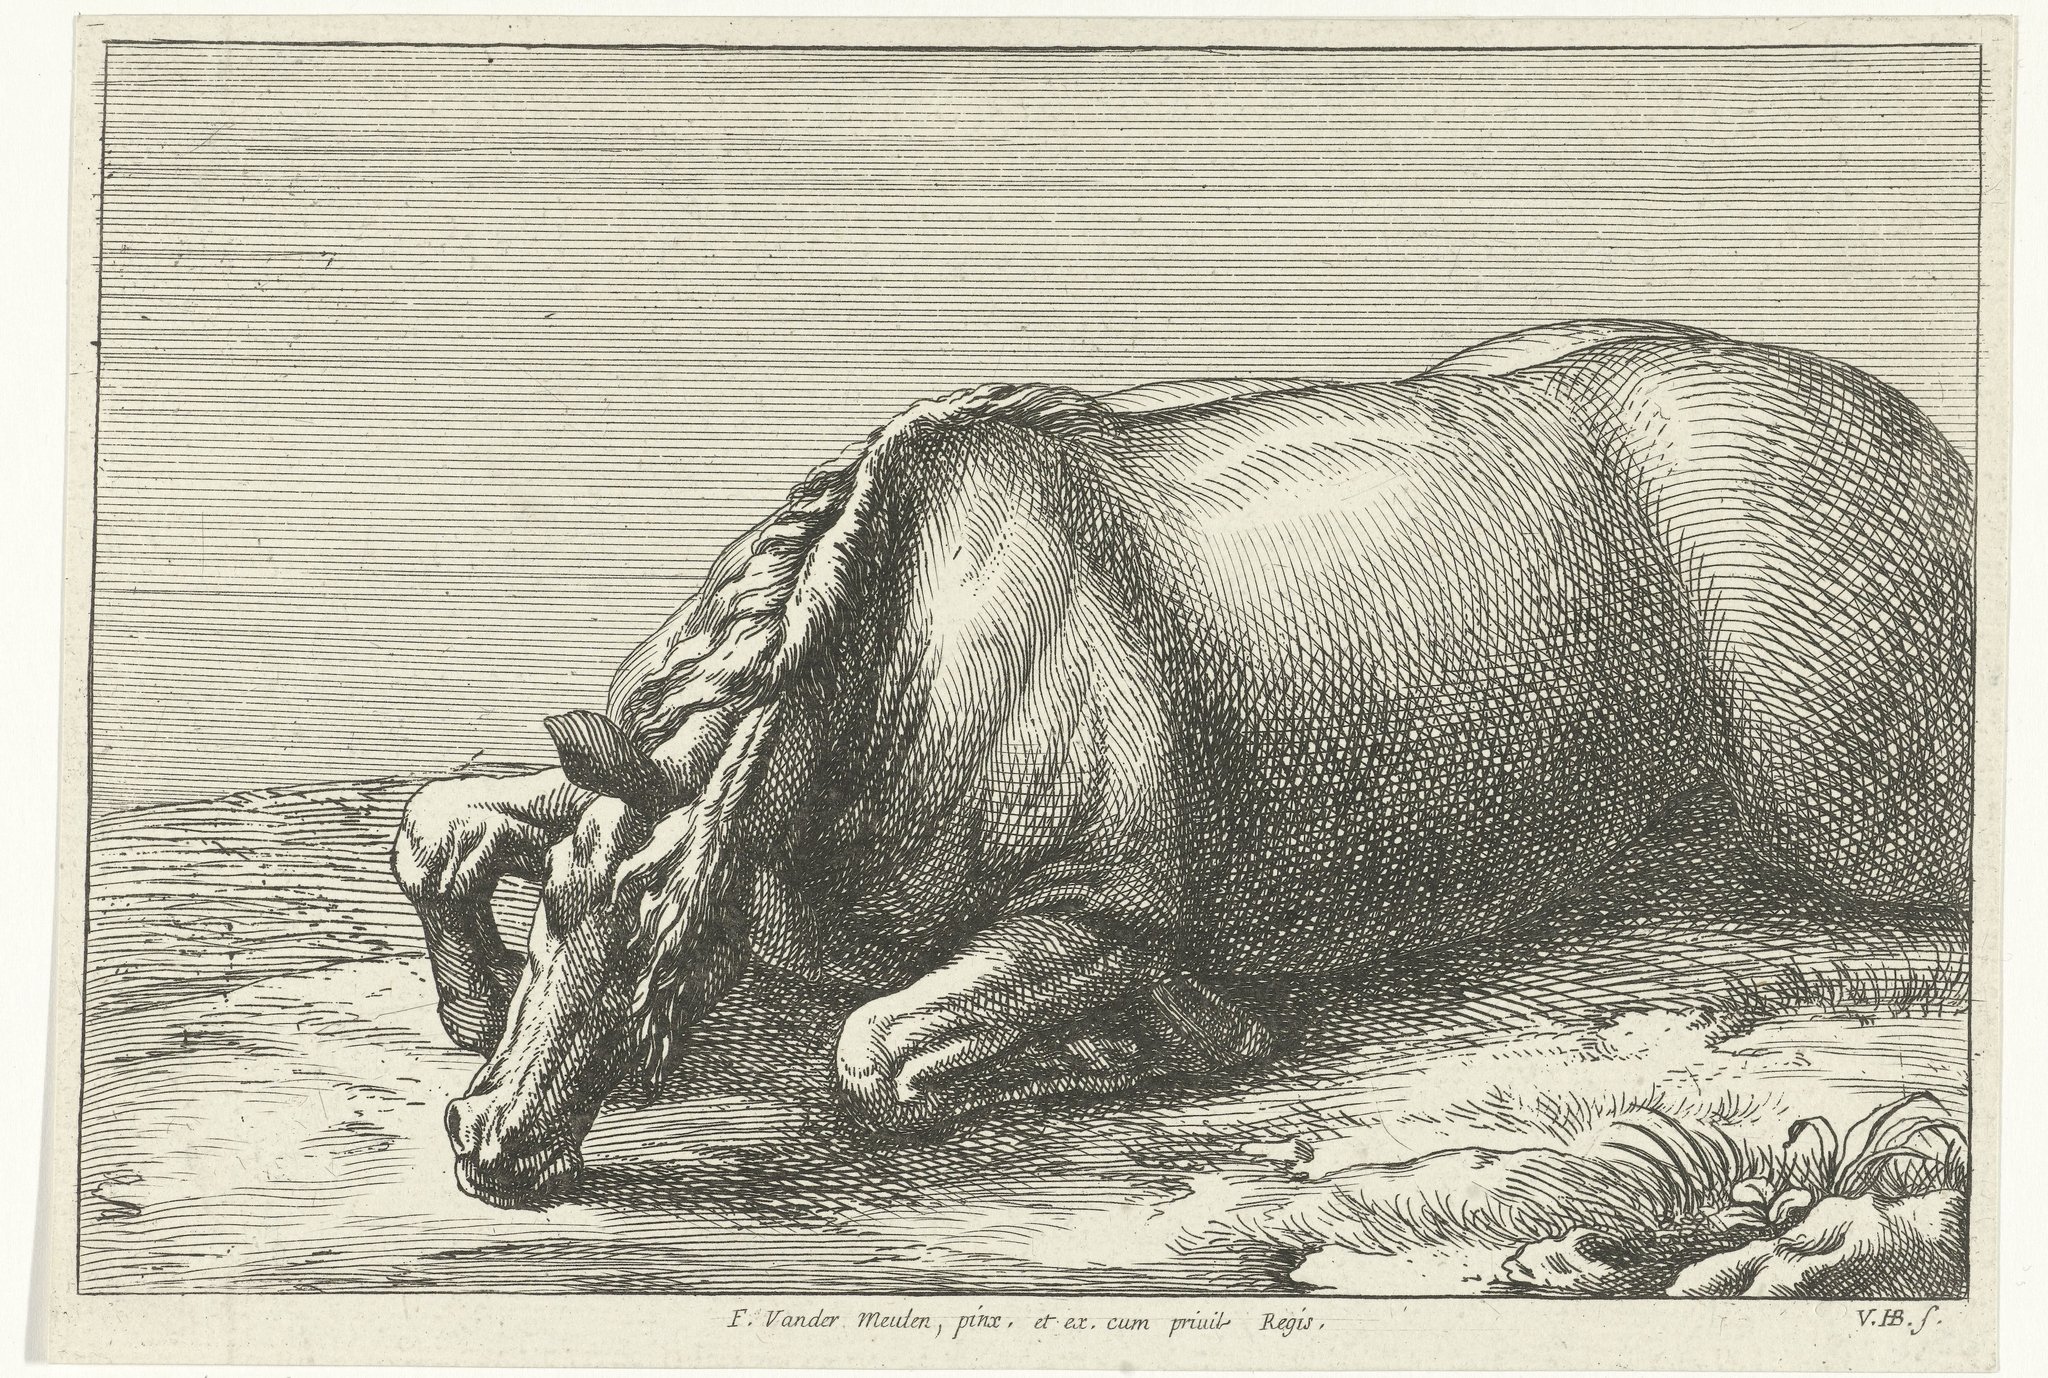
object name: print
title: Gesneuveld paard op de linkerzij gezien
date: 1674-1733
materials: paper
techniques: engraving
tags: horse (+ dying animal; death of animal; dead animal)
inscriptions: collector's mark: Lugt 2228, inscription: ‘Namly 1770’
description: Op de buik liggend paard op de linkerzij gezien.